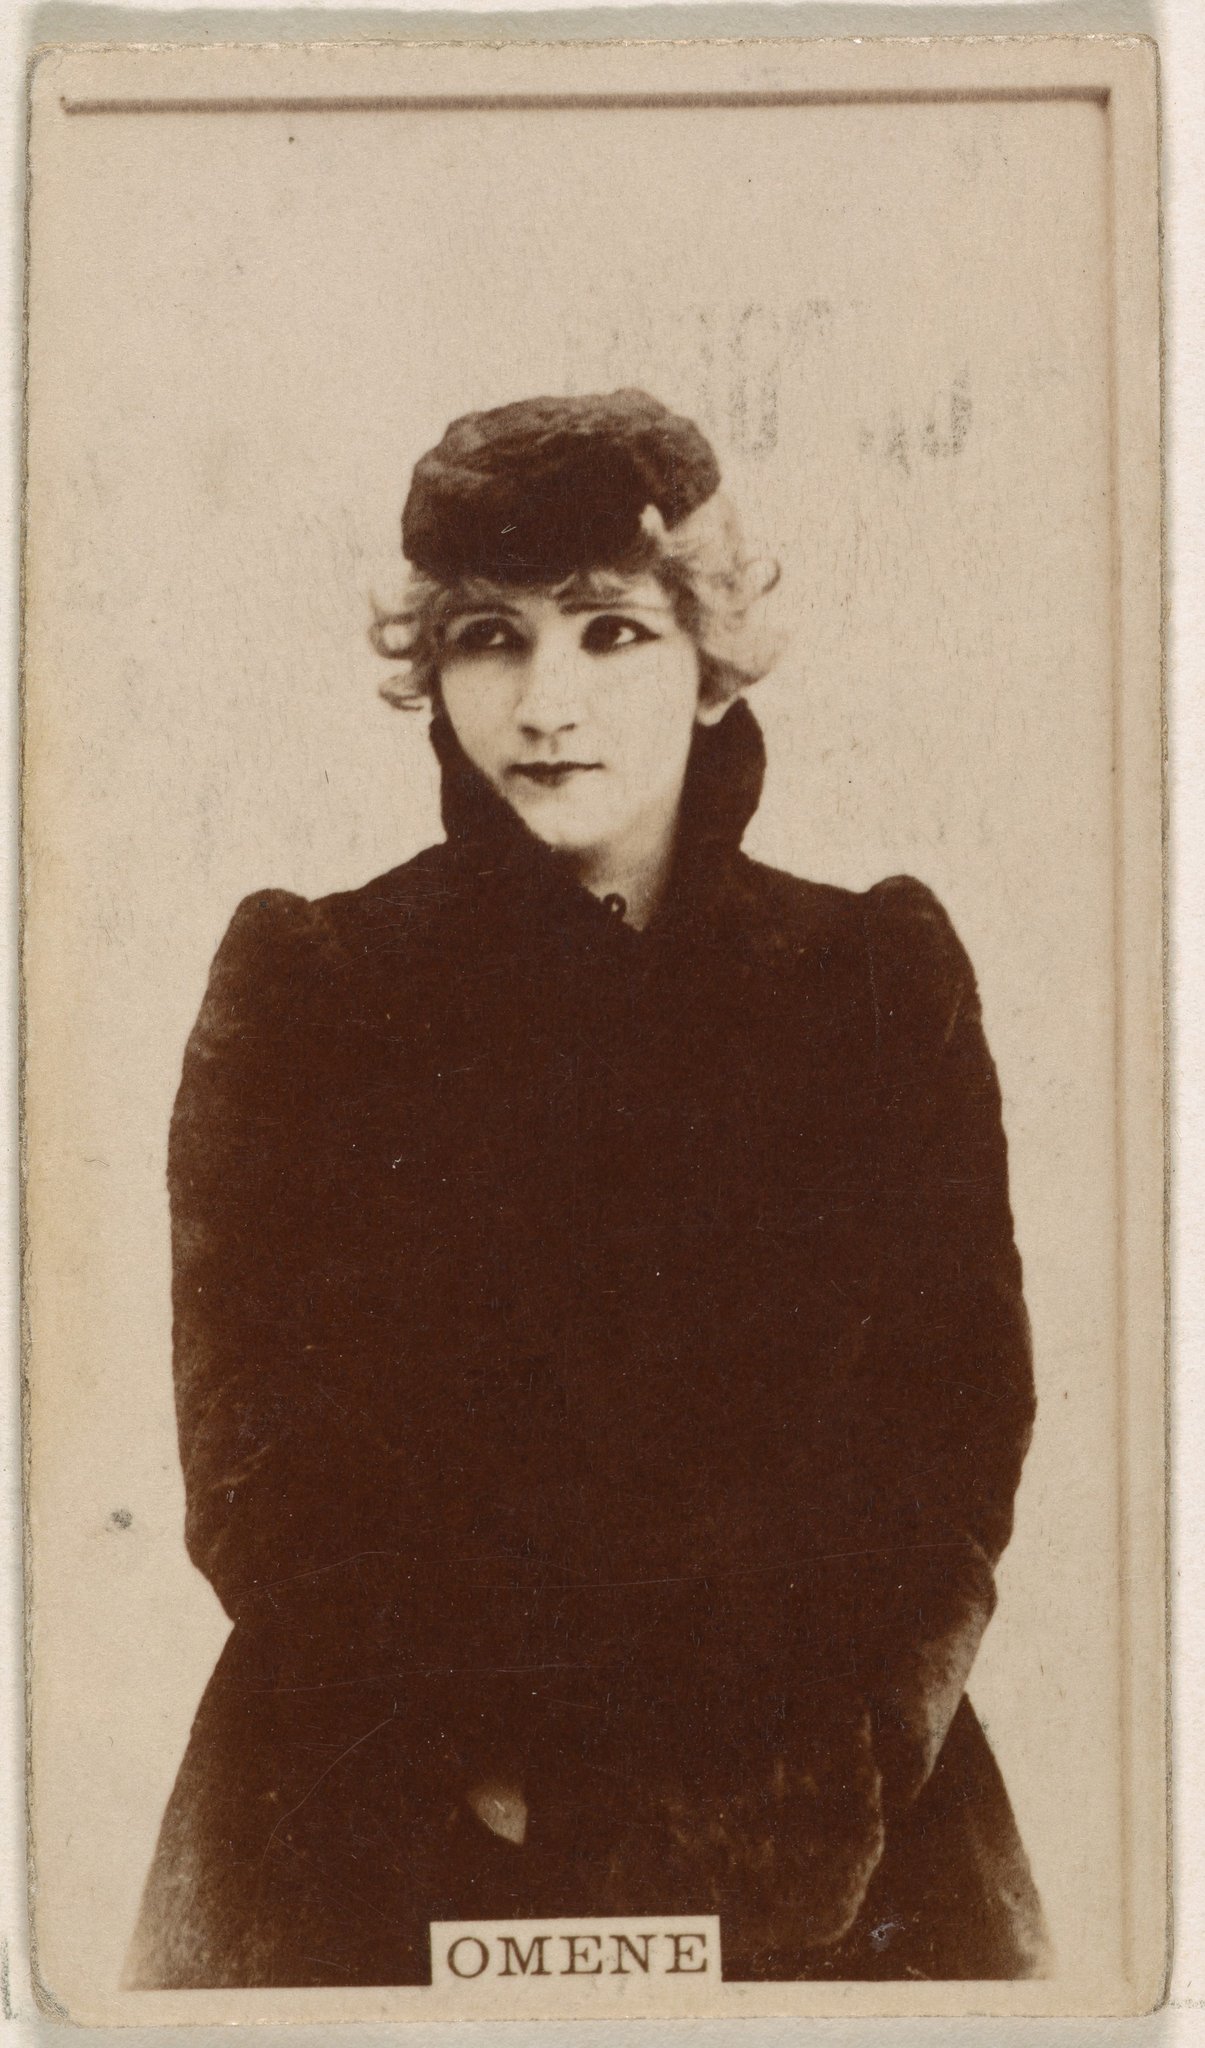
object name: photograph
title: Omene, from the Actresses series (N245) issued by Kinney Brothers to promote Sweet Caporal Cigarettes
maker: kinney brothers tobacco company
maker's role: publisher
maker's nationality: american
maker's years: 1869-2011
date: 1890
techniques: albumen silver print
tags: portraits,women,actresses